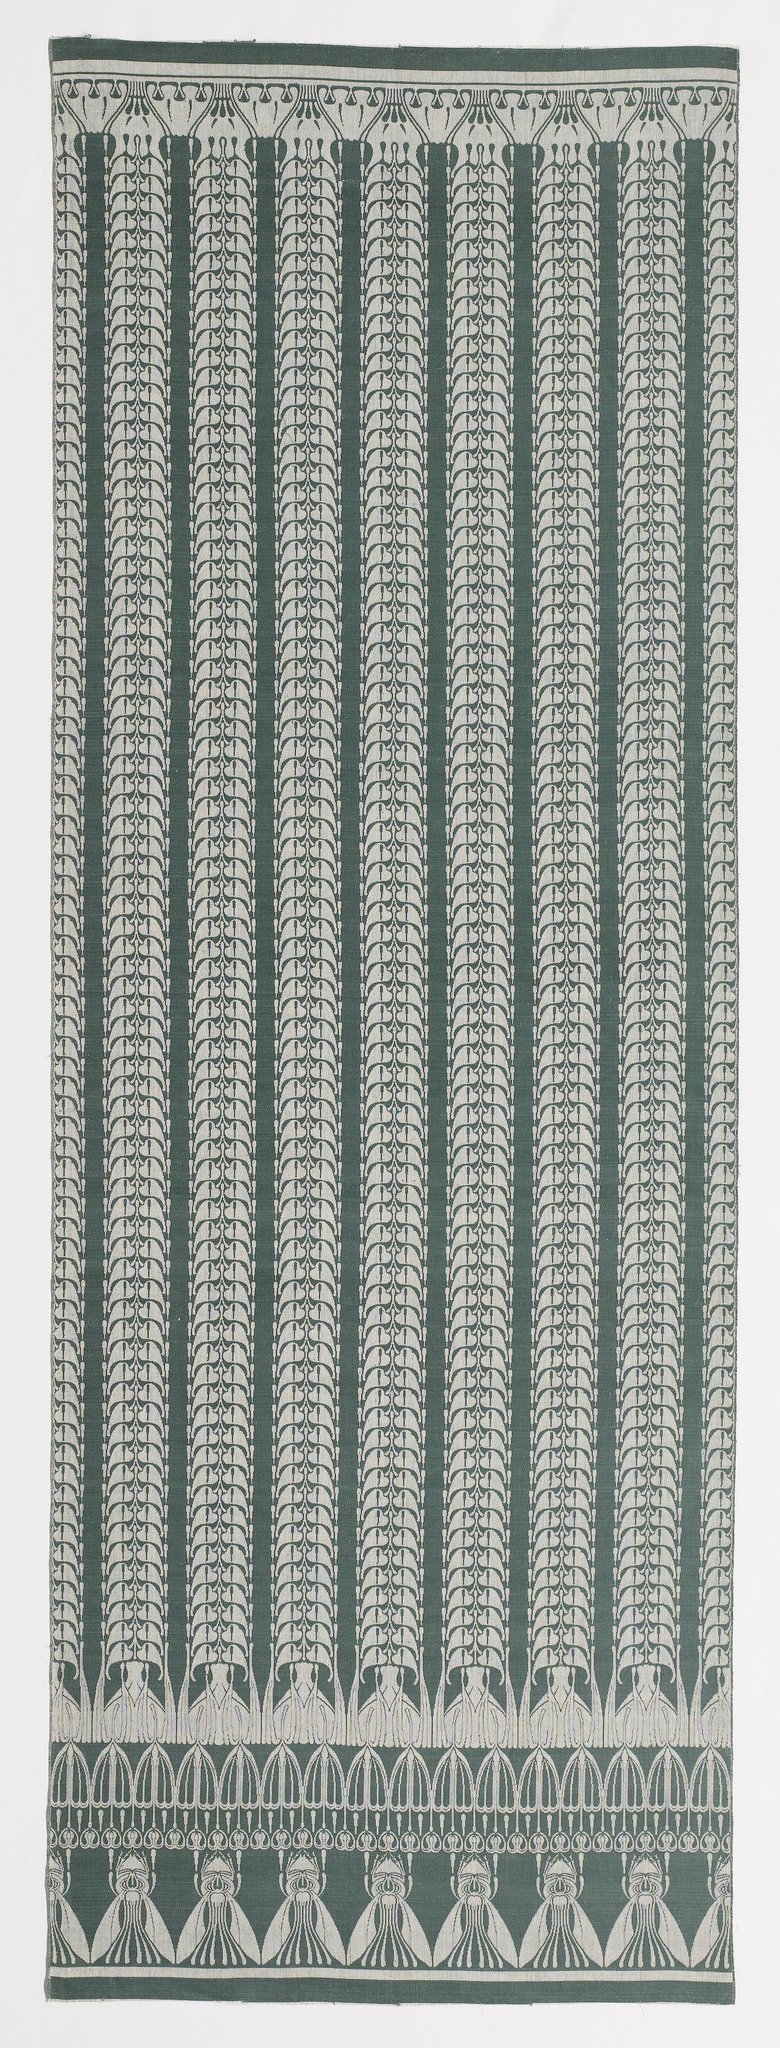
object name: upholstered wall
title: Wandbespanning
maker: chris lebeau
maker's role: draughtsman, print maker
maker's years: 1878-1945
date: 1911-1915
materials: linen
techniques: damask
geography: eindhoven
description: Donkergroene damasten wandbespanning met een dessin van bijen.